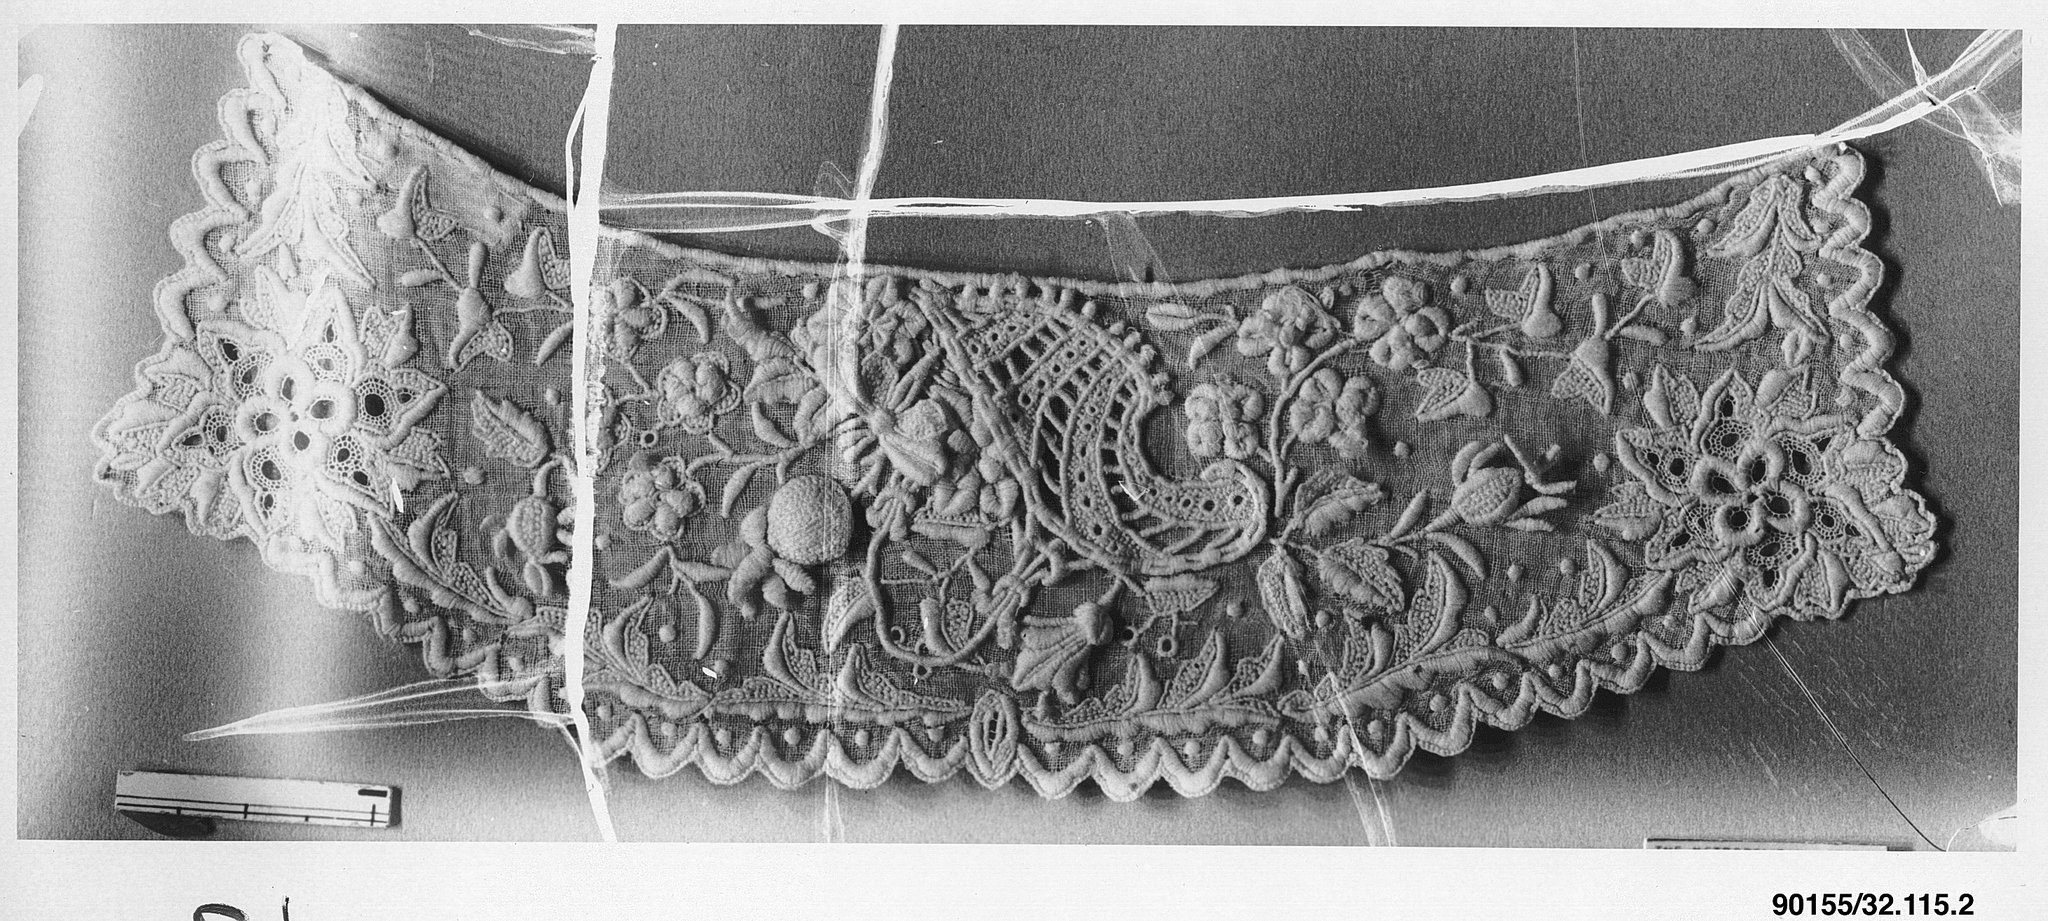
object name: cuff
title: Cuffs (part of a set)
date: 1801-1900